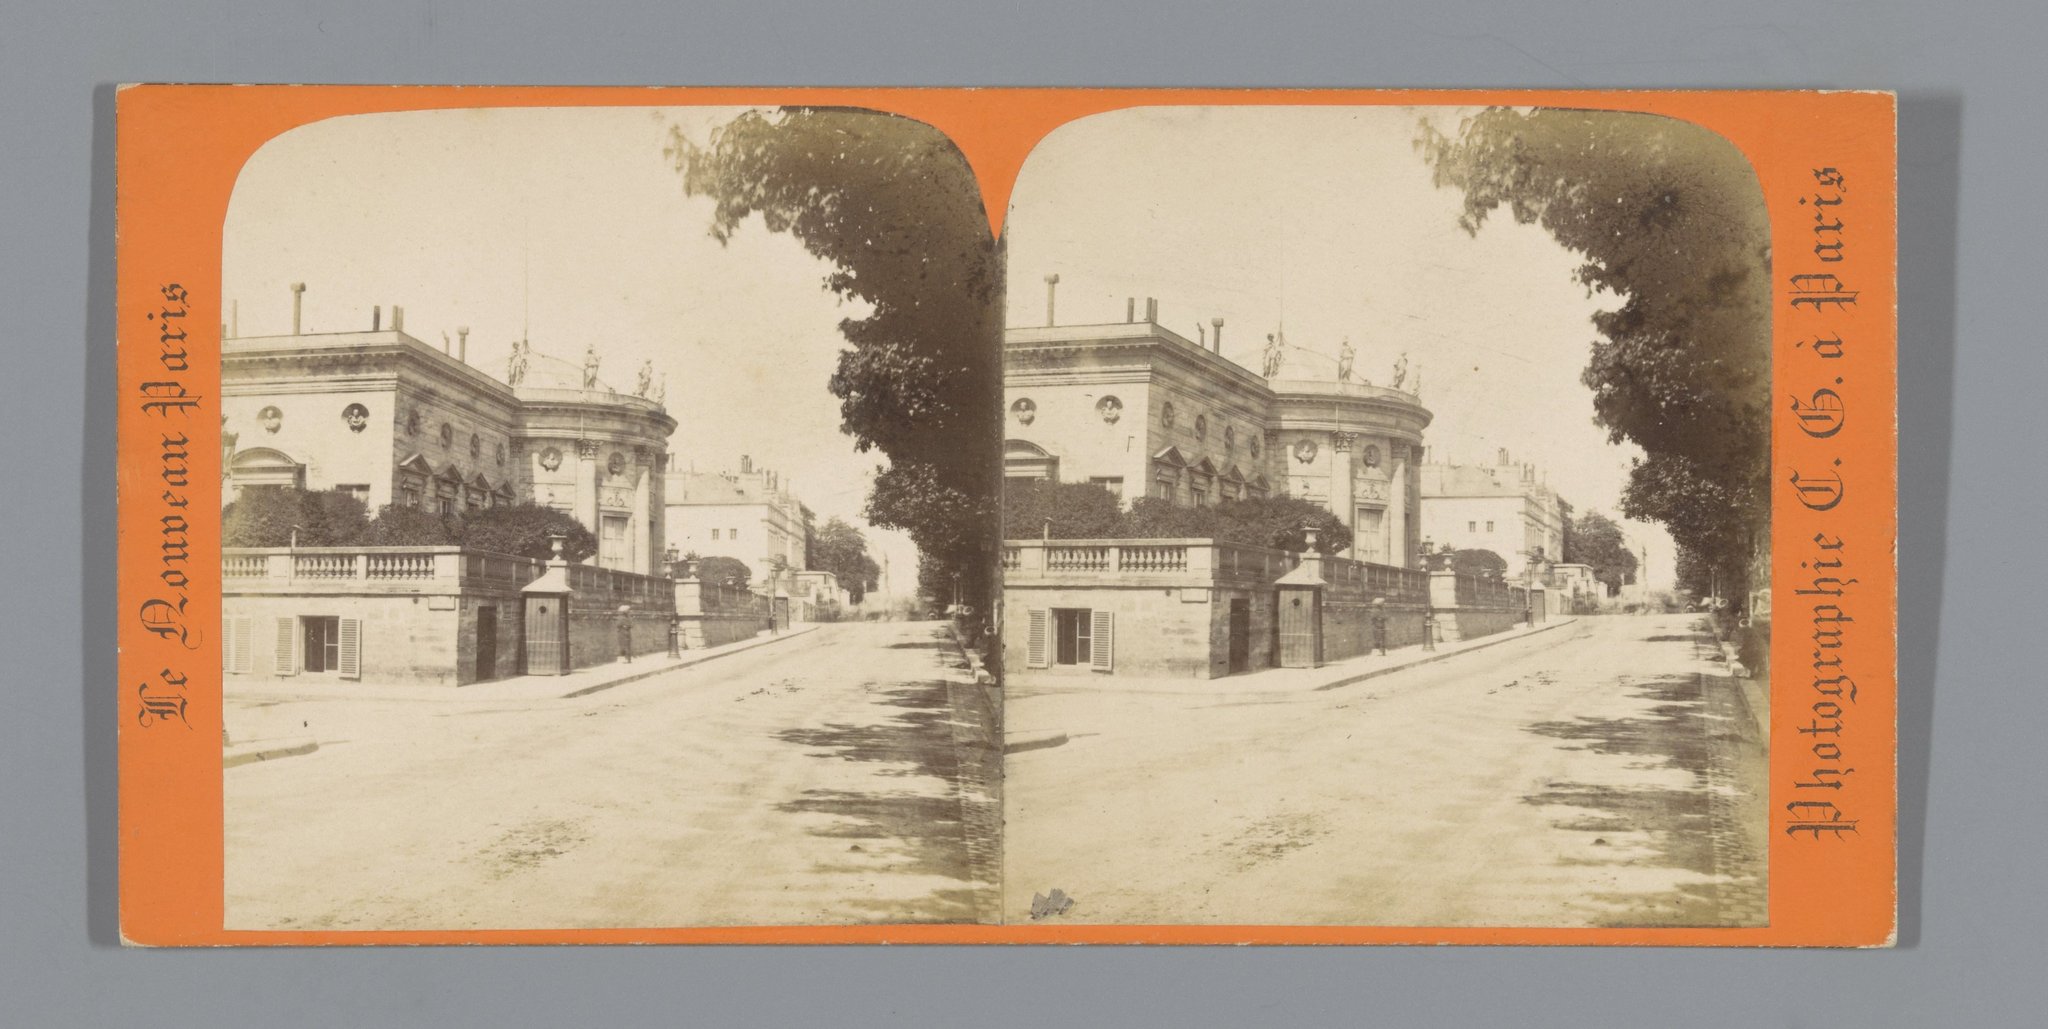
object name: stereograph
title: Gezicht op het Palais de la Légion d'Honneur te Parijs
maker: charles gérard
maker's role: fotograaf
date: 1860-1870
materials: cardboard, photographic support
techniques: albumen print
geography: paris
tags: hôtel, i.e. small palace in city, façade (of house or building)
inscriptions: inscription: ‘La legion d'honneur’, inscription: ‘Photographie C. G. à Paris.’